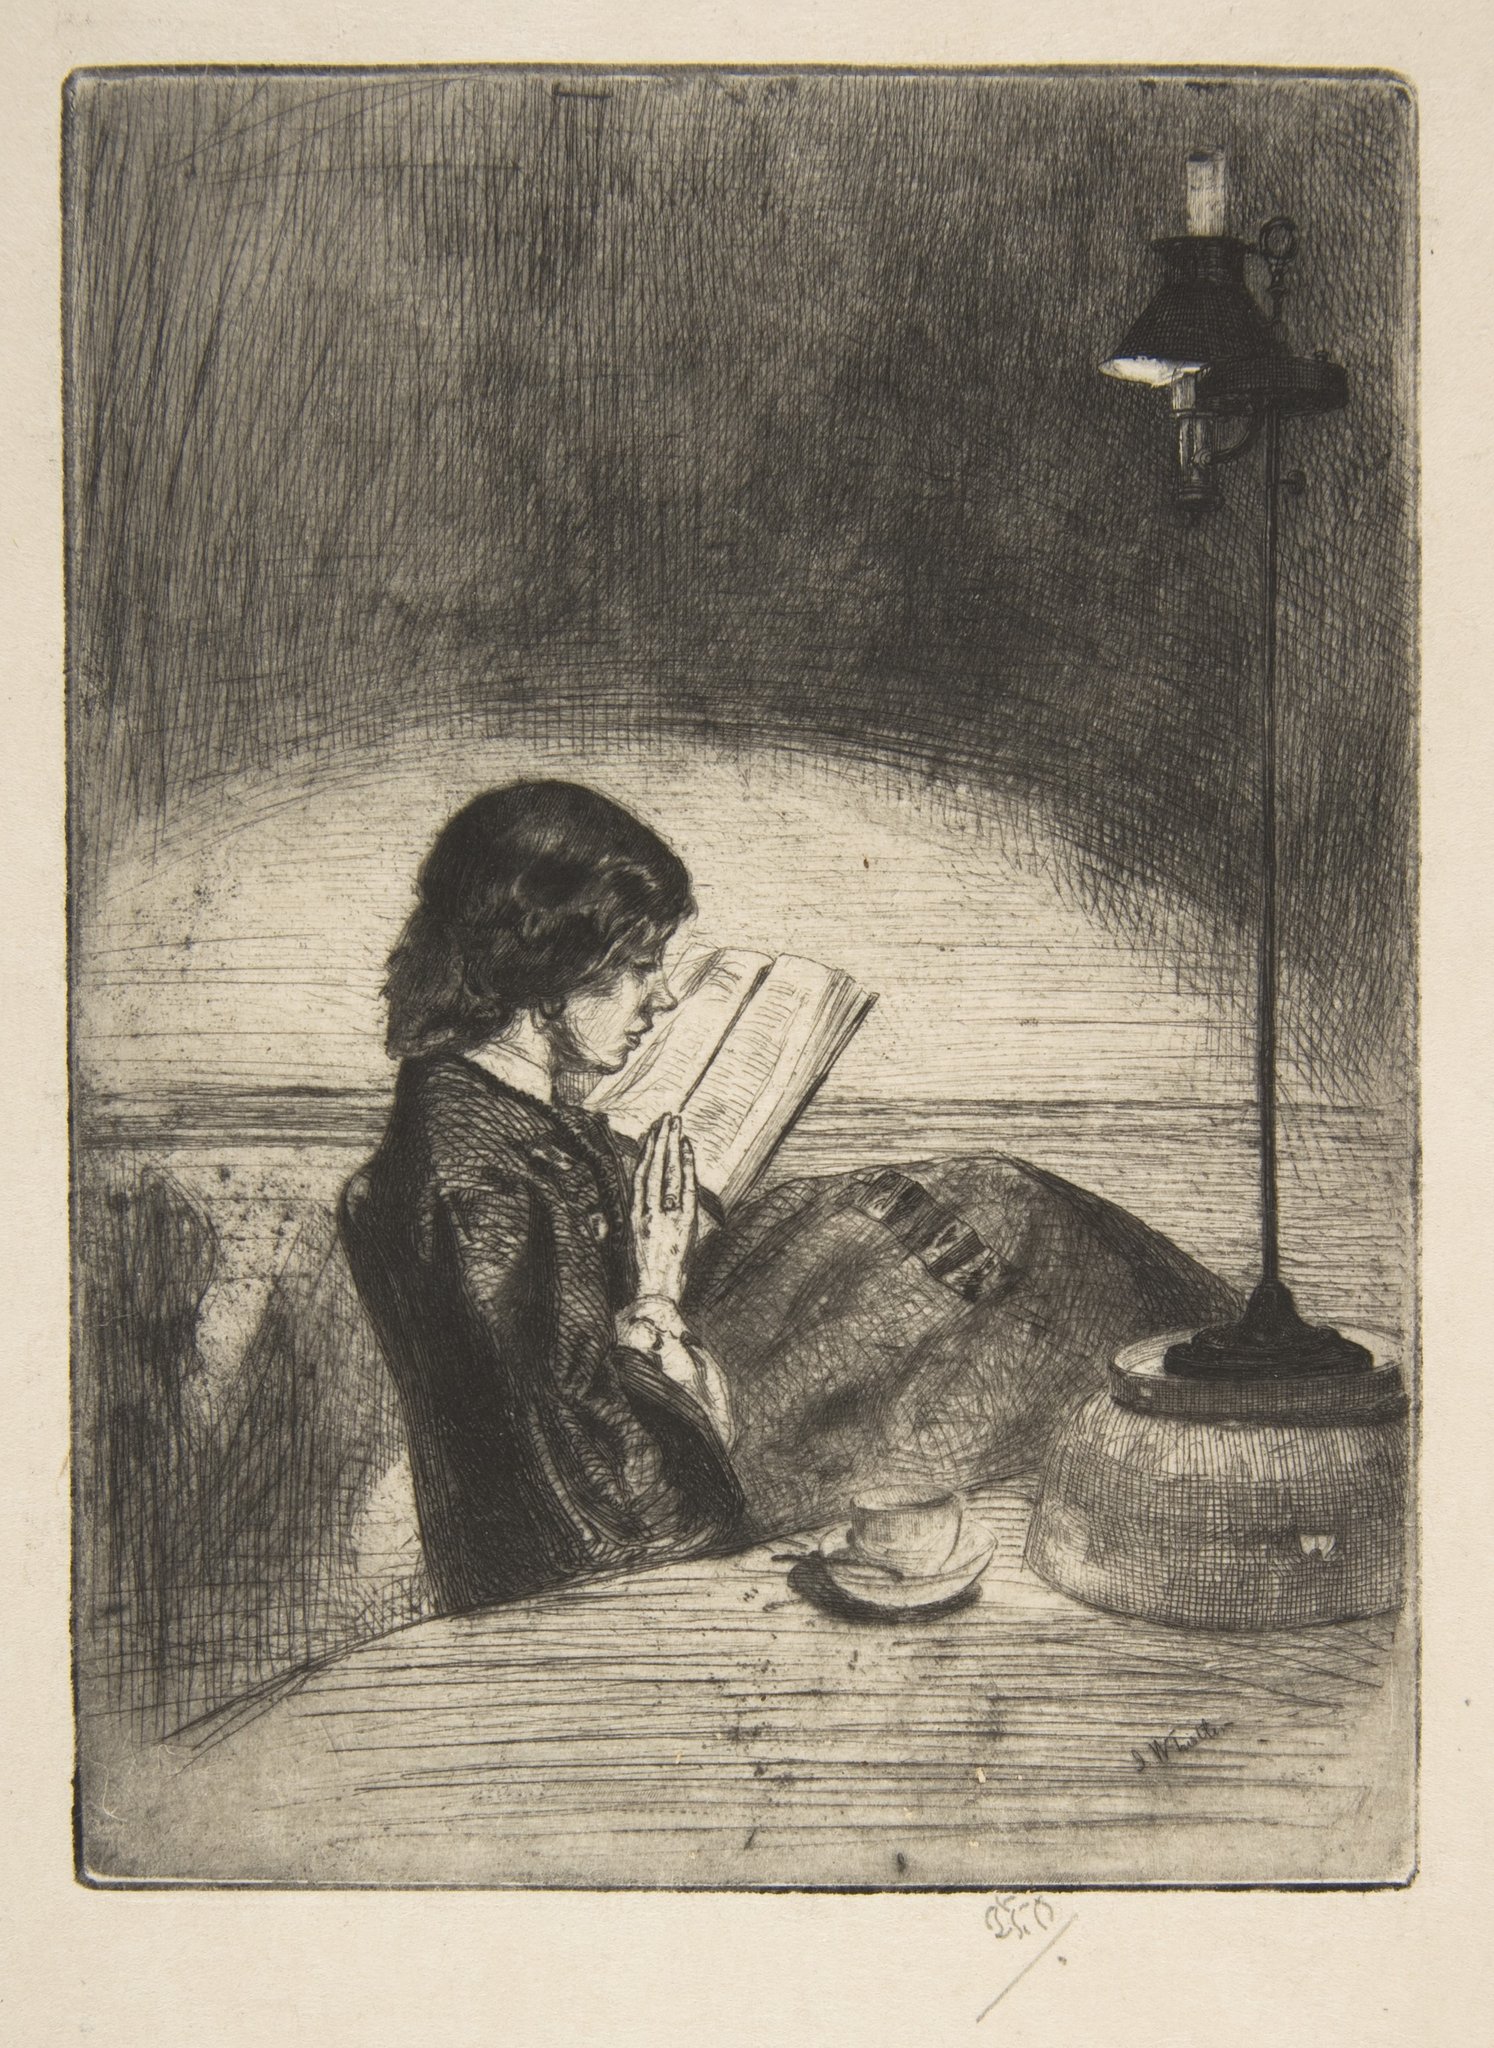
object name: print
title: Reading by Lamplight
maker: james mcneill whistler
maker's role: artist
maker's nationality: american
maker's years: 1834-1903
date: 1859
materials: ink, ivory, paper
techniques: drypoint, etching, printing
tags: women,reading,lamps